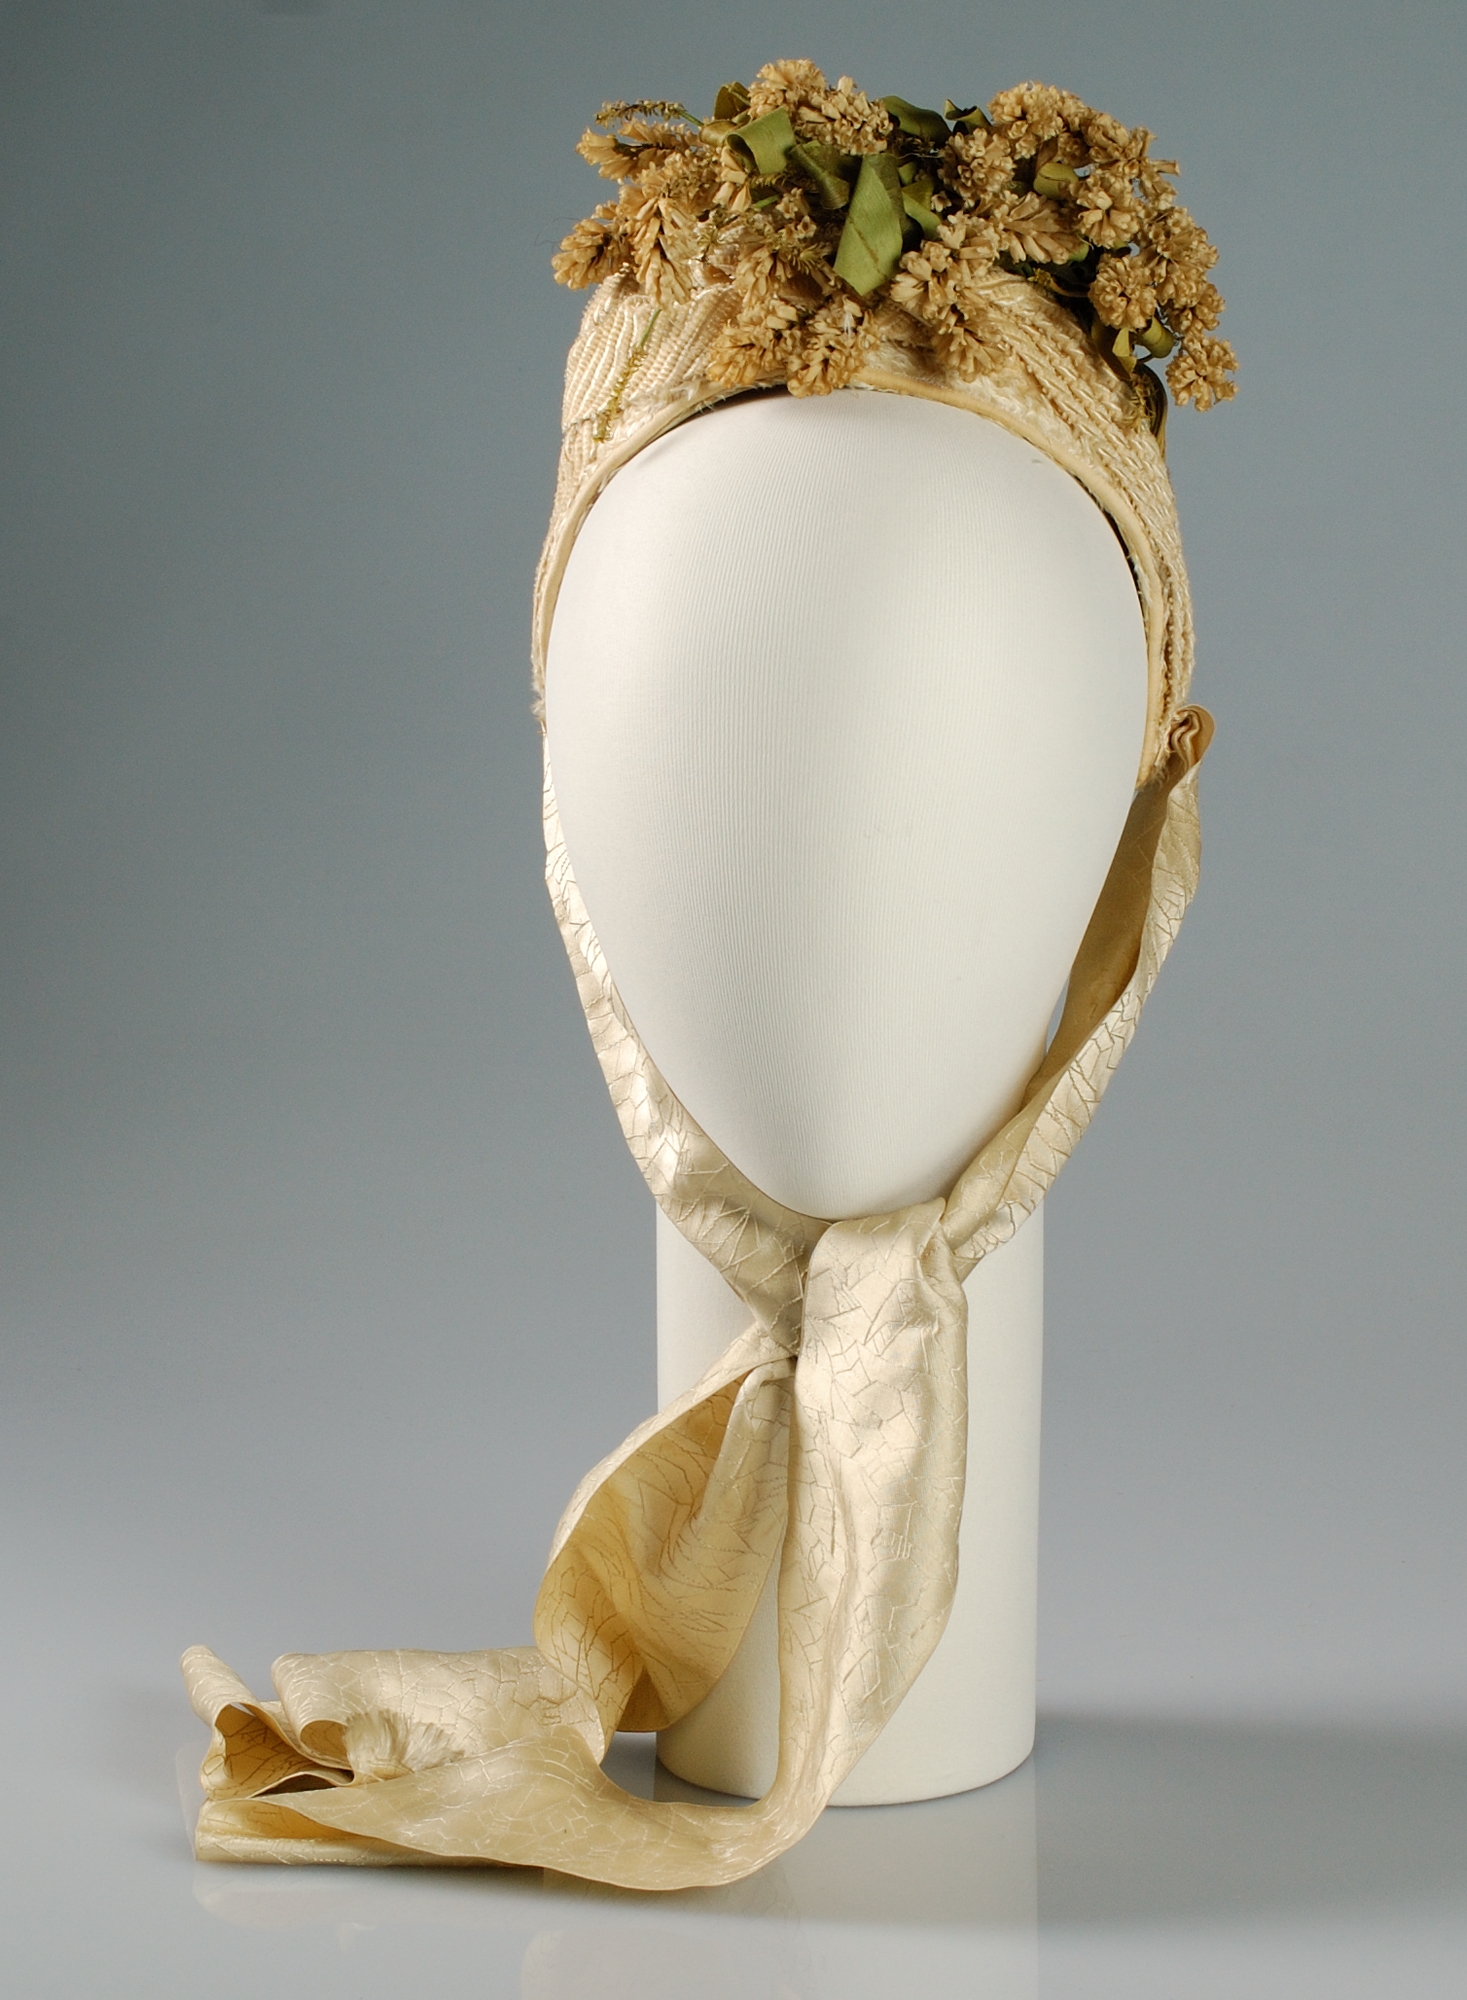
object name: bonnet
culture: american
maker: balch, price & company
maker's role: department store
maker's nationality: american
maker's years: 1869-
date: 1880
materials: cotton, hair, silk, wool